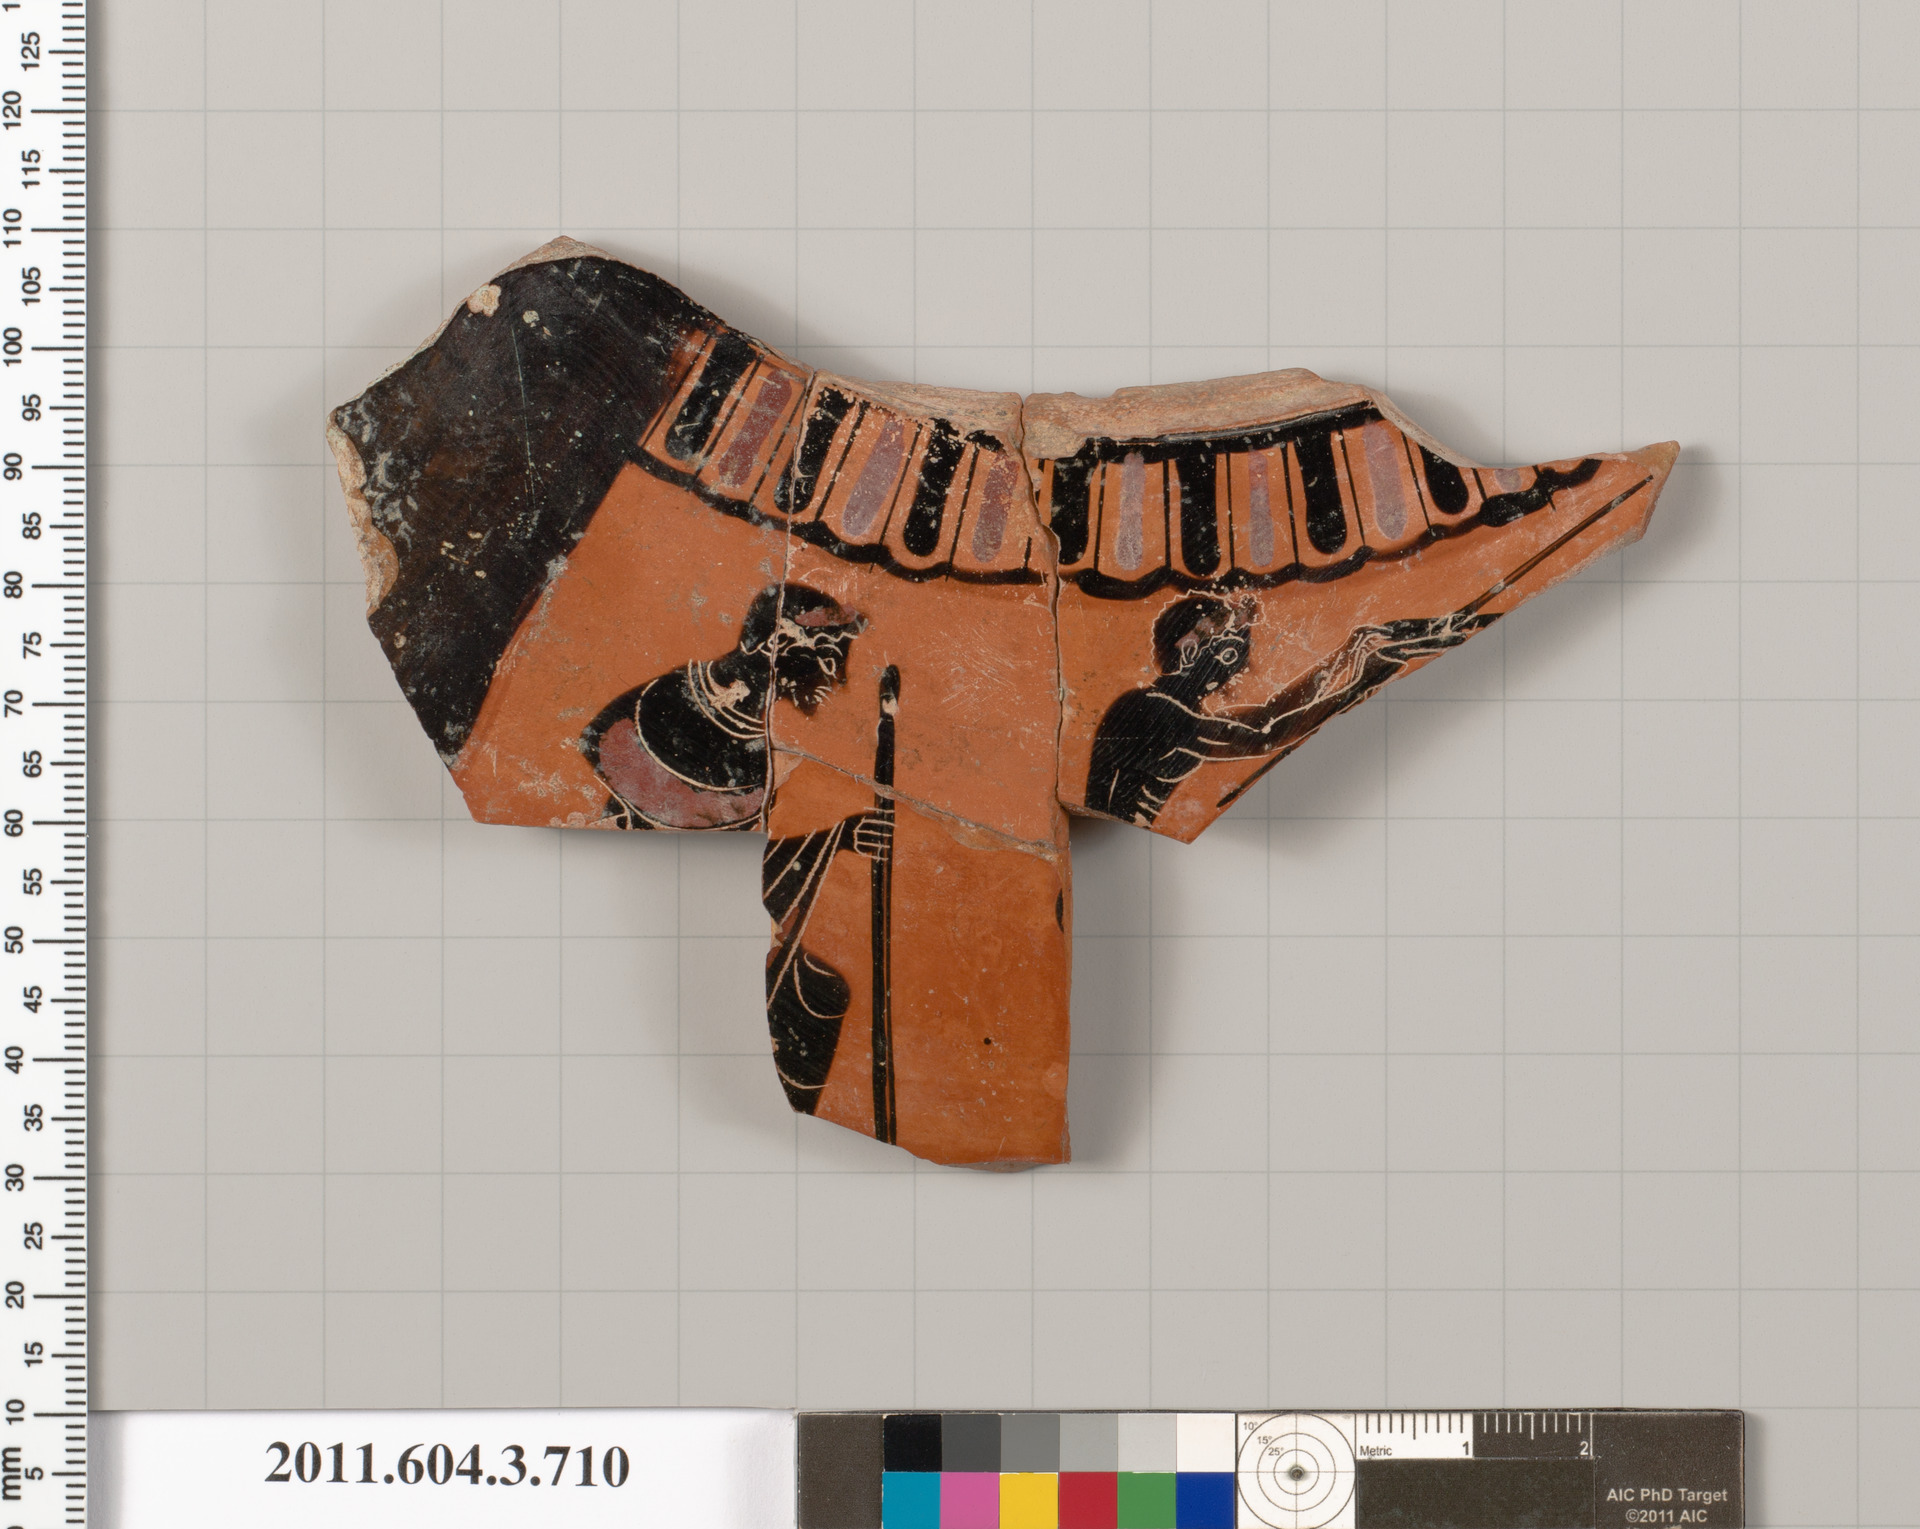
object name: hydria fragment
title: Terracotta fragment of a hydria (water jar)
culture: greek, attic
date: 550-526 BCE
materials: terracotta